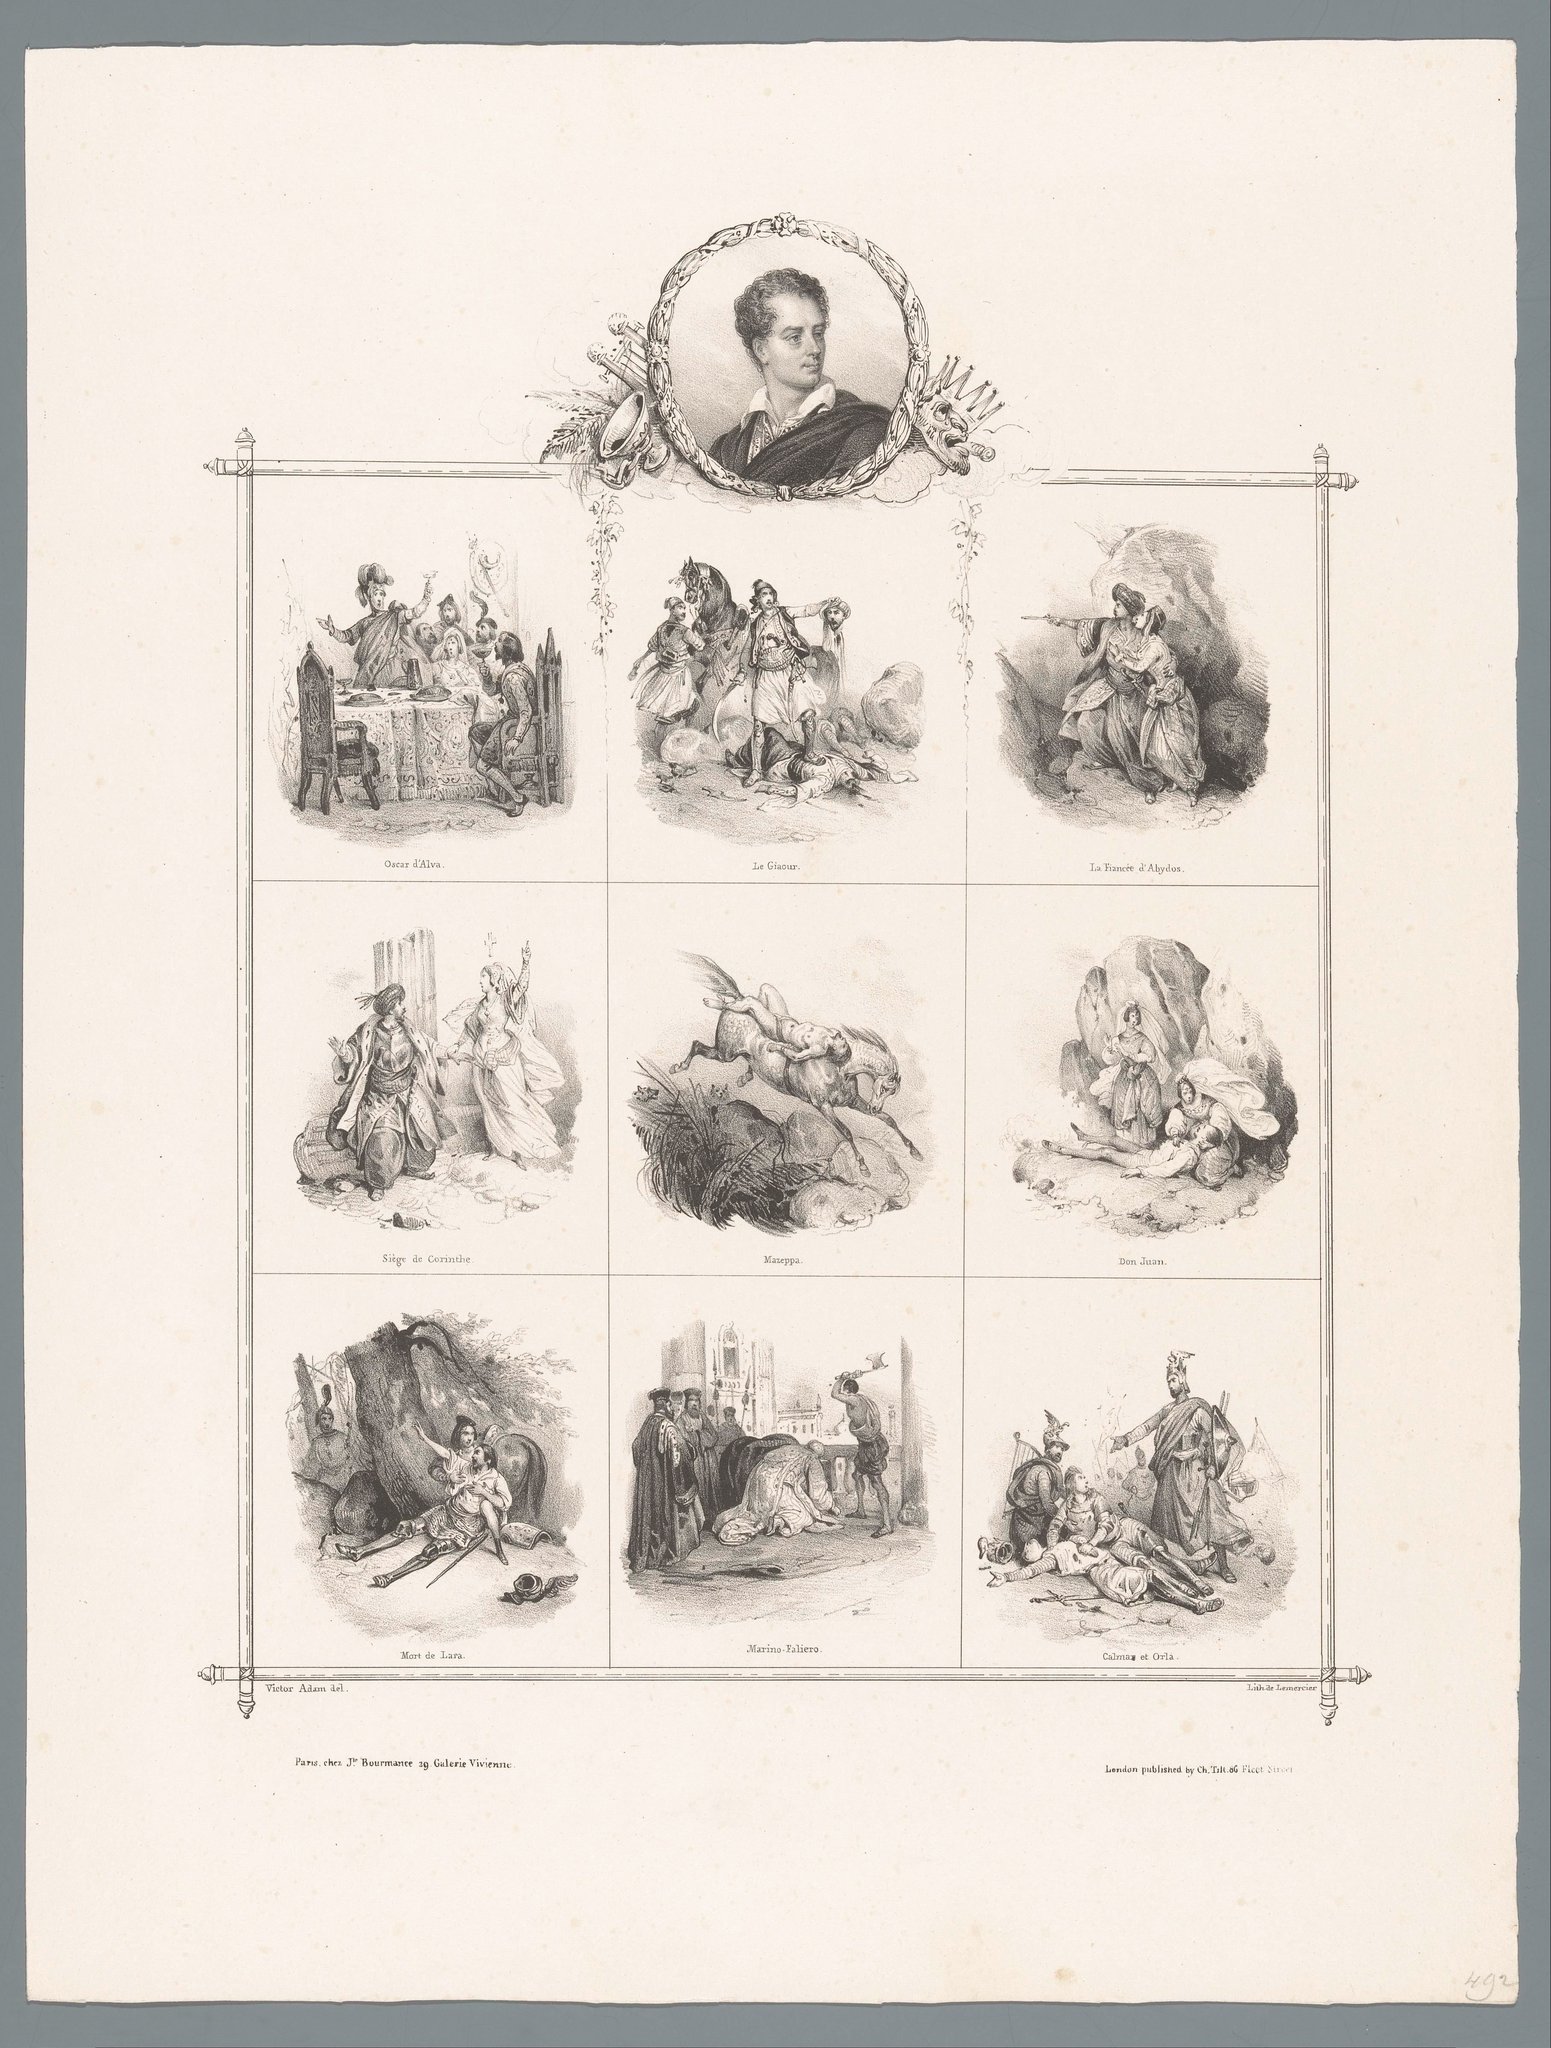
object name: print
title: Portraits d'écrivains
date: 1835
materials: paper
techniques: lithograph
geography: paris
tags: lord byron, historical persons, portrait of a writer, (scenes from) specific works of literature (with author, title)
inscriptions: number: ‘492’, collector's mark: Lugt 2228